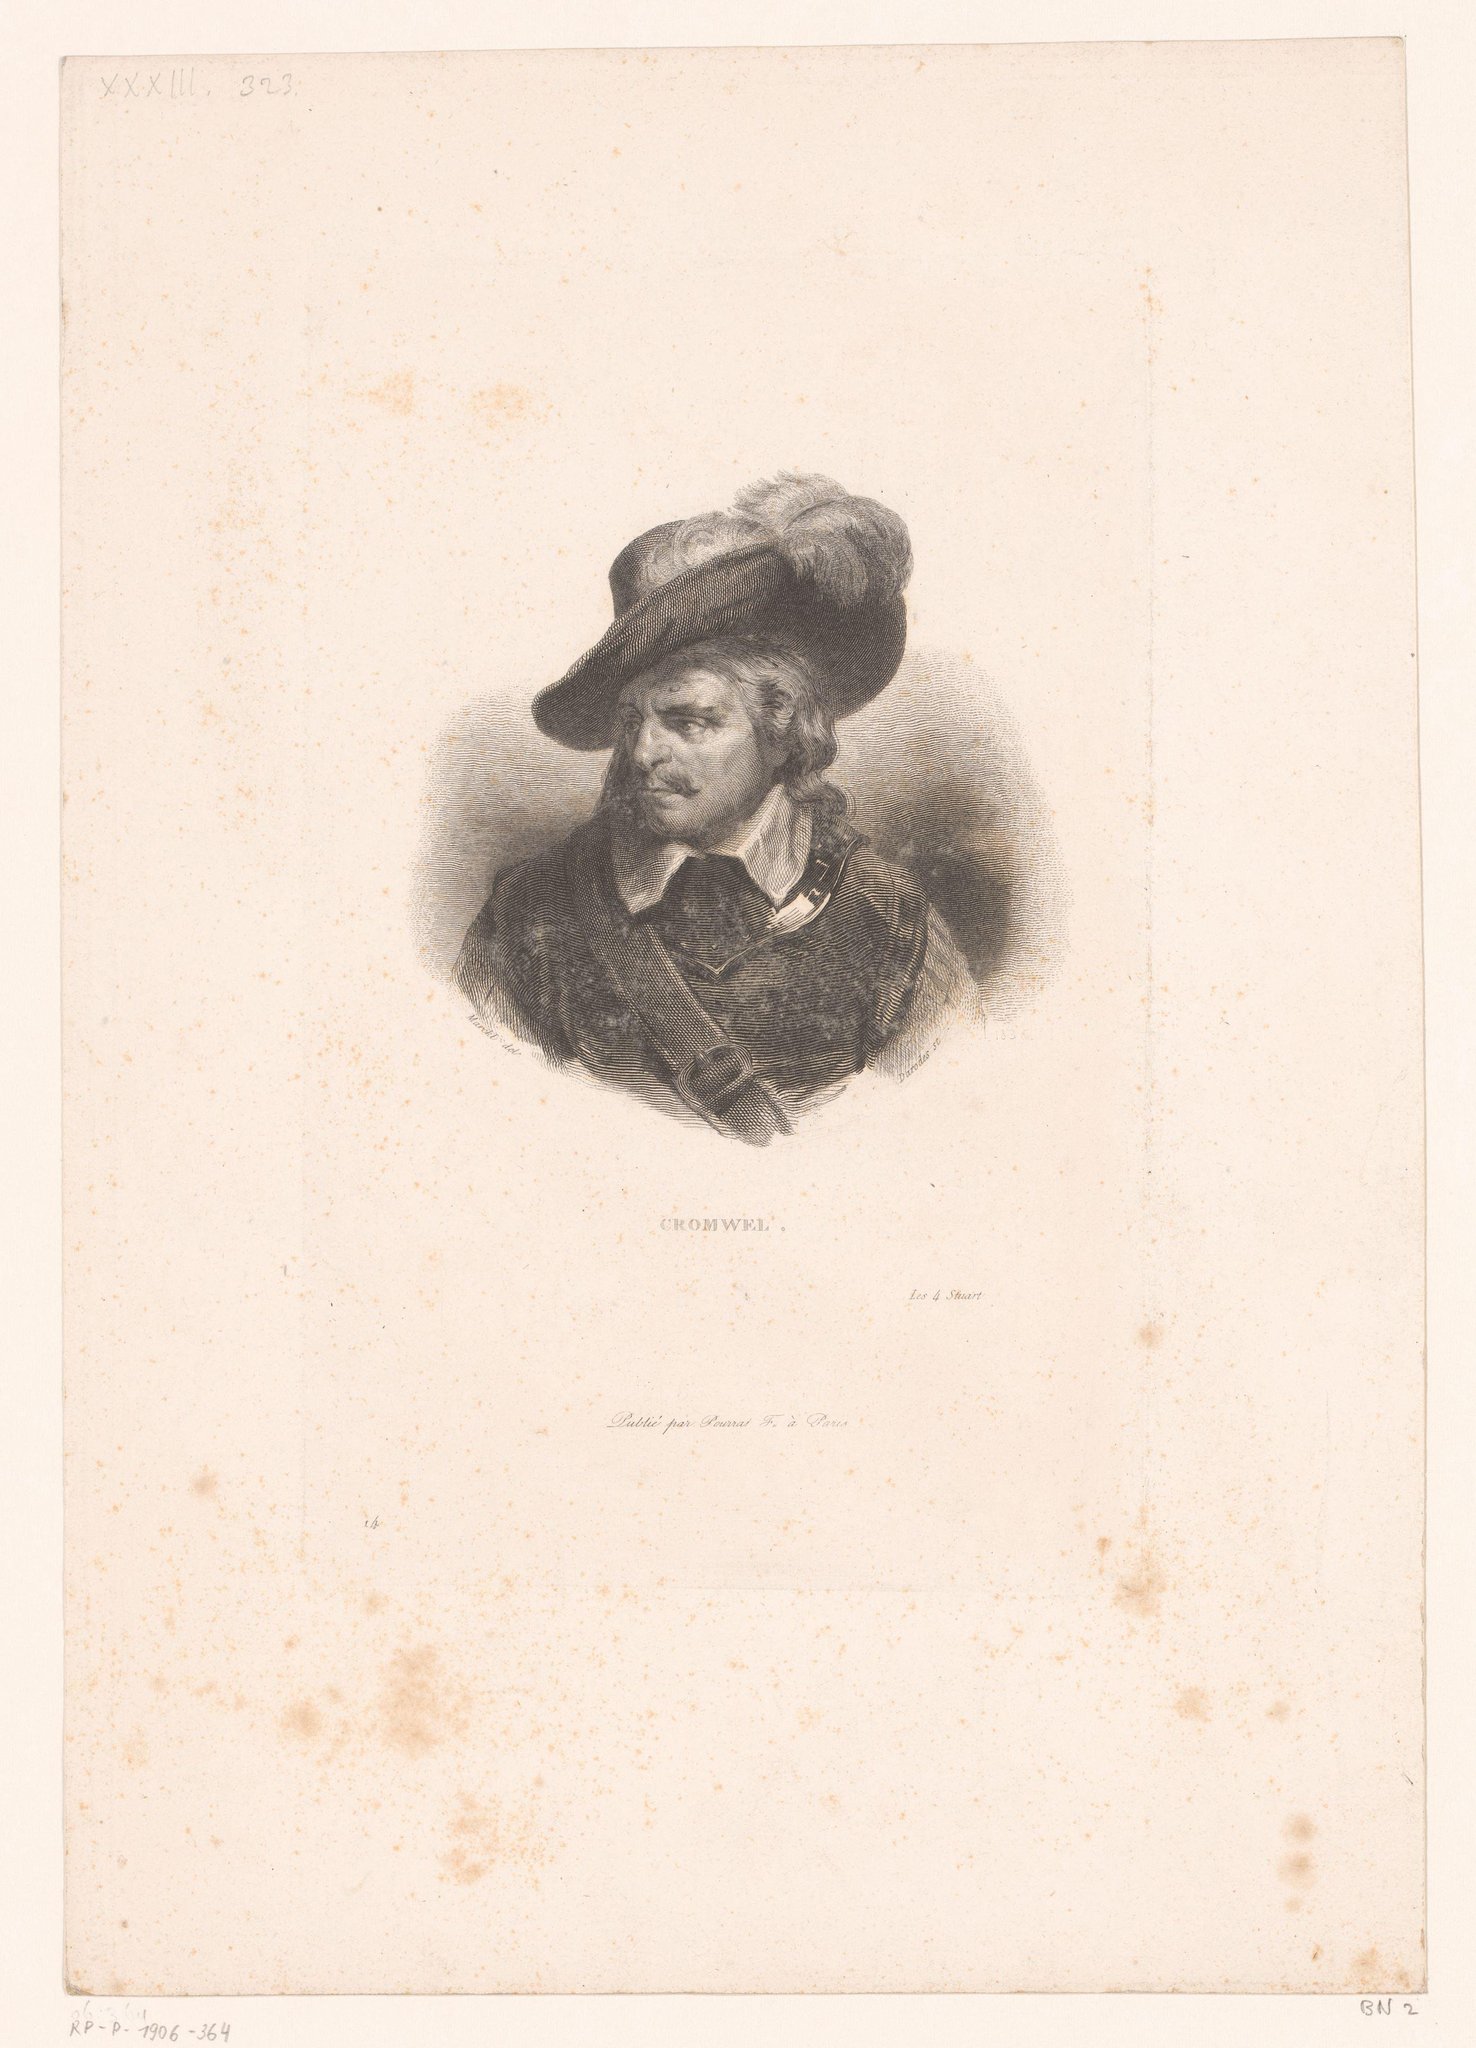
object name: print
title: Cromwel.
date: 1845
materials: paper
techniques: engraving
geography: paris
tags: london, oliver cromwell, historical persons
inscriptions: collector's mark: Lugt 2228